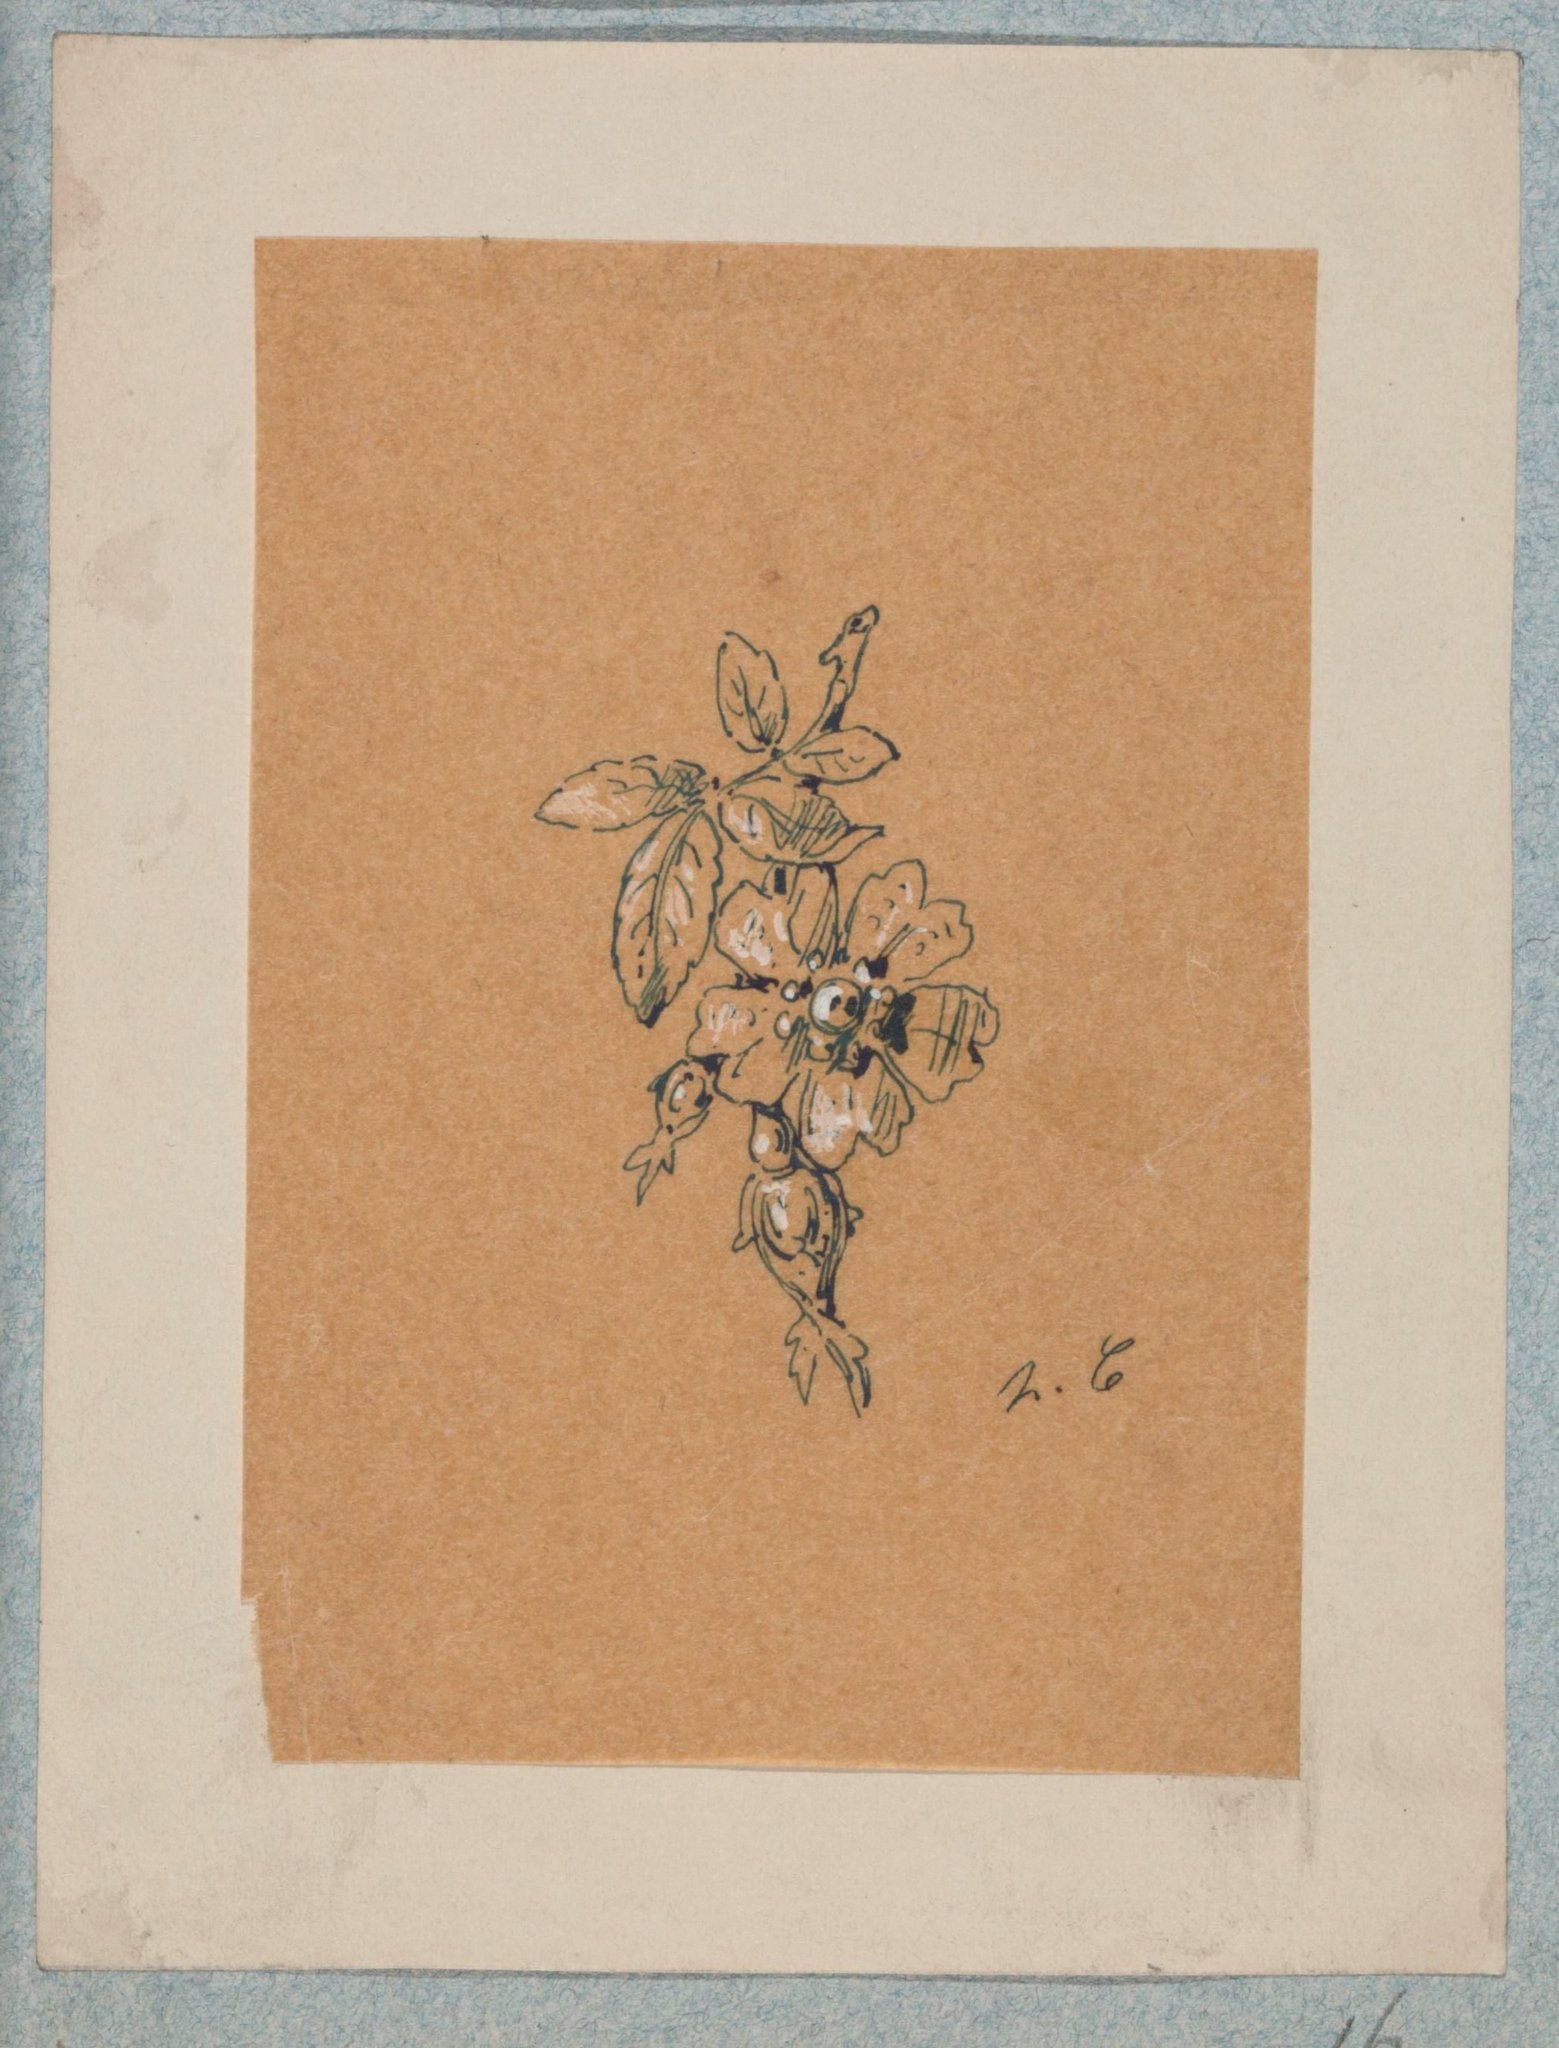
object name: design drawing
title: Ontwerp voor broche in de vorm van een bloementak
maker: henri cameré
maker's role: designer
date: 1864-1894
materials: paint, ink, paper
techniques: pen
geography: paris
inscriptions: signature: ‘h.C.’